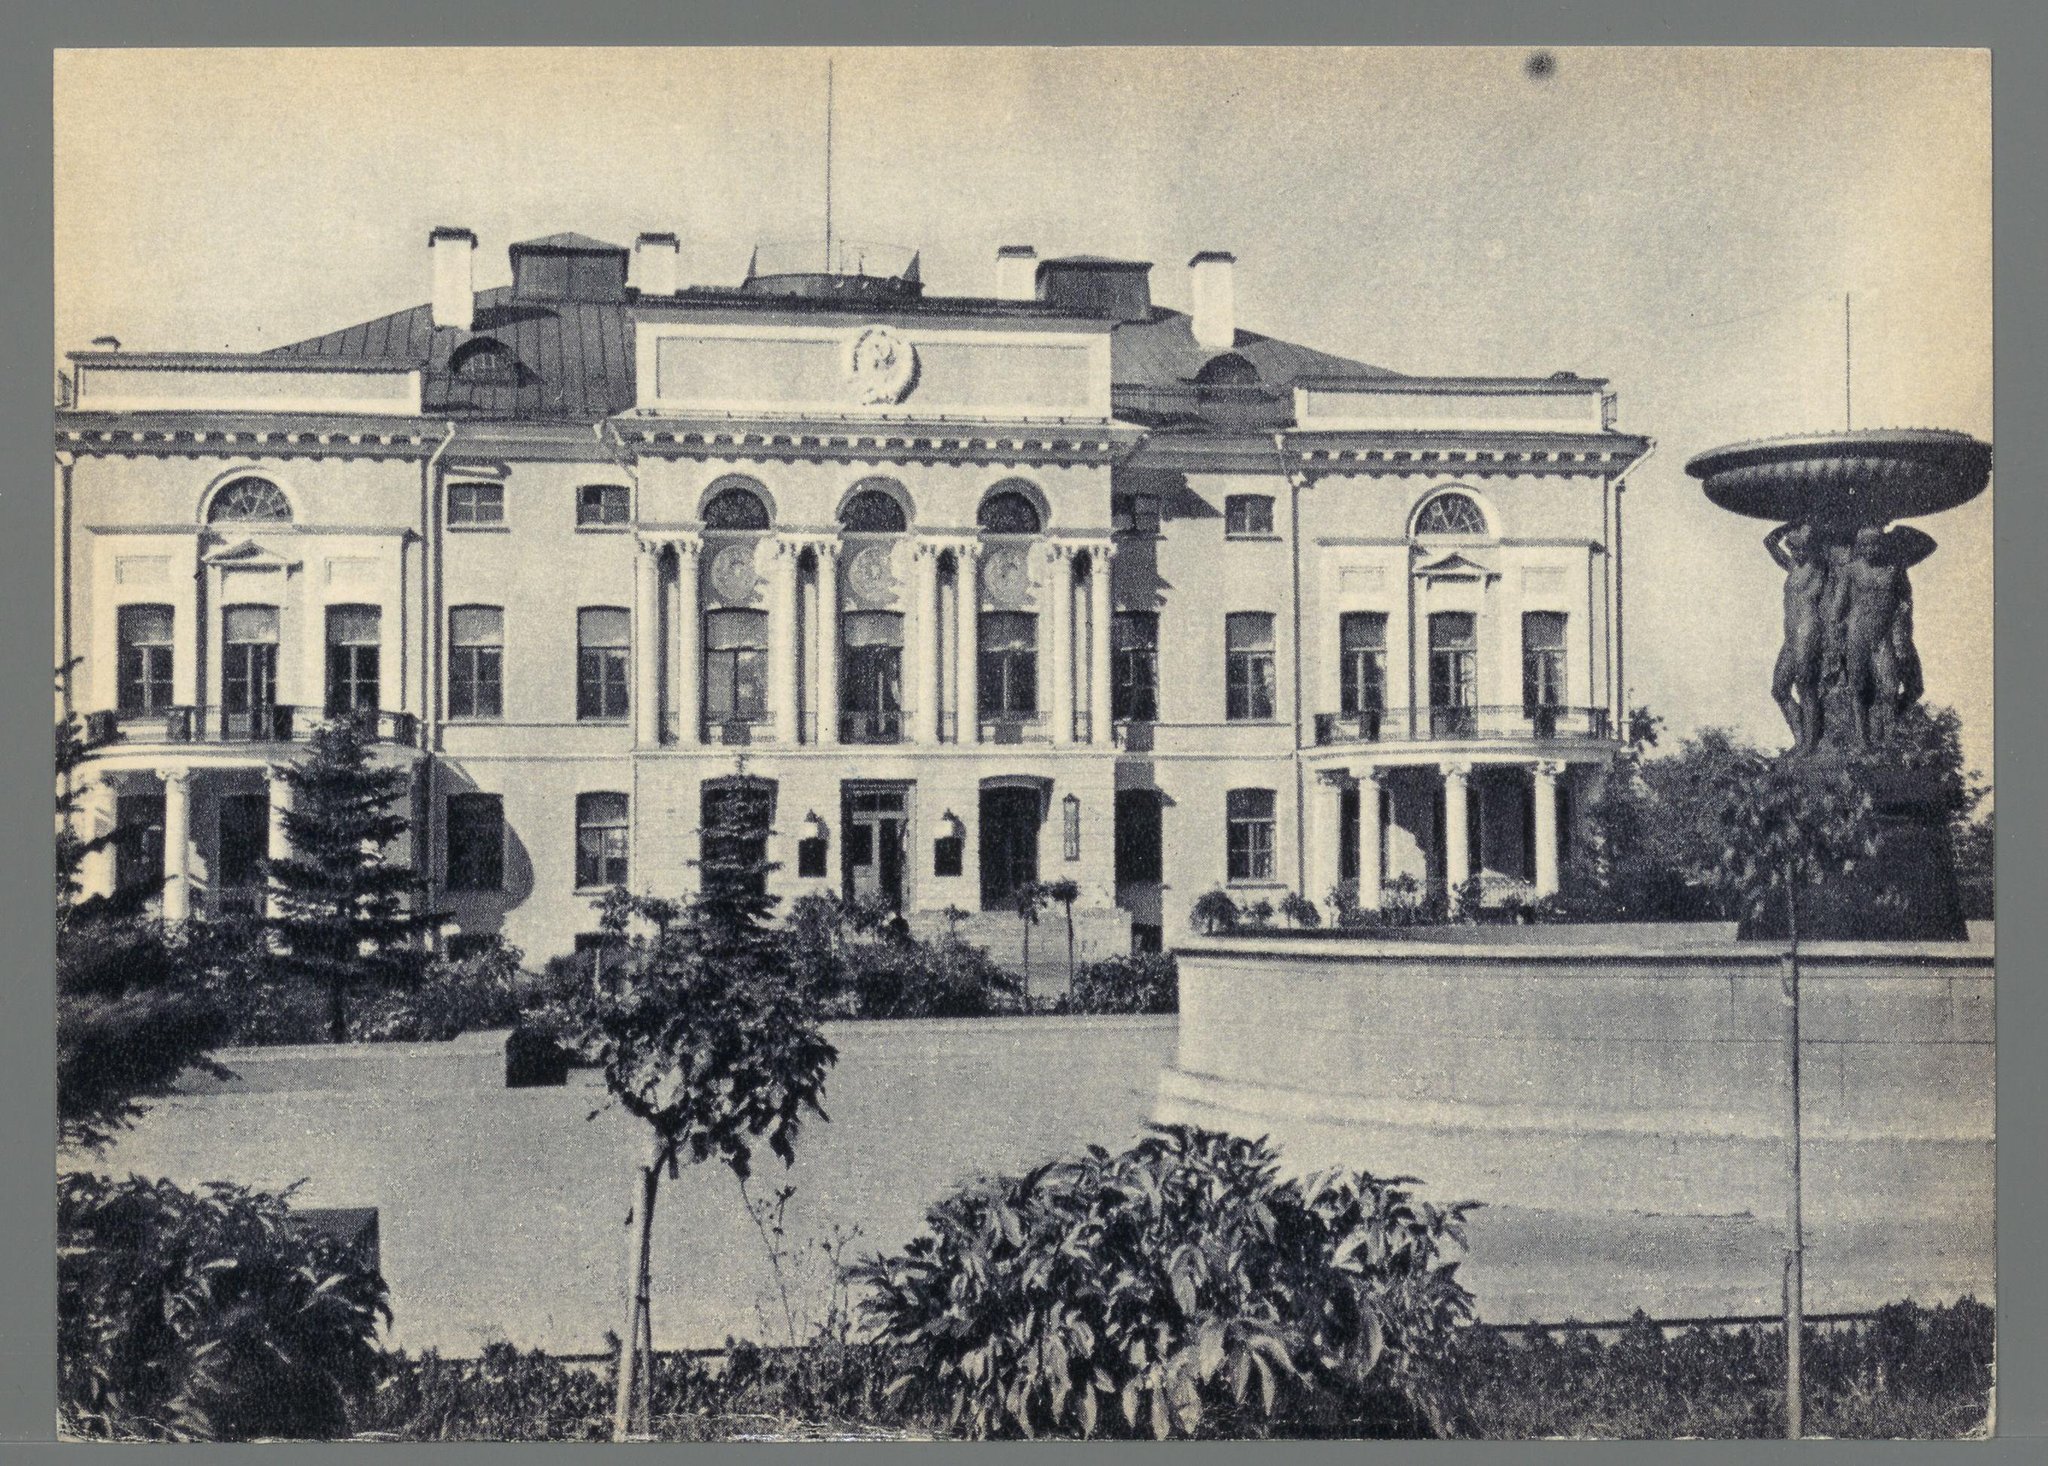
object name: photomechanical print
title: Gezicht op de Academie van Wetenschappen te Moskou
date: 1957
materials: cardboard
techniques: rotogravure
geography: moscow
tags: university building, college, ornamental fountain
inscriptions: date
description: De titel op object staat in het Russisch.